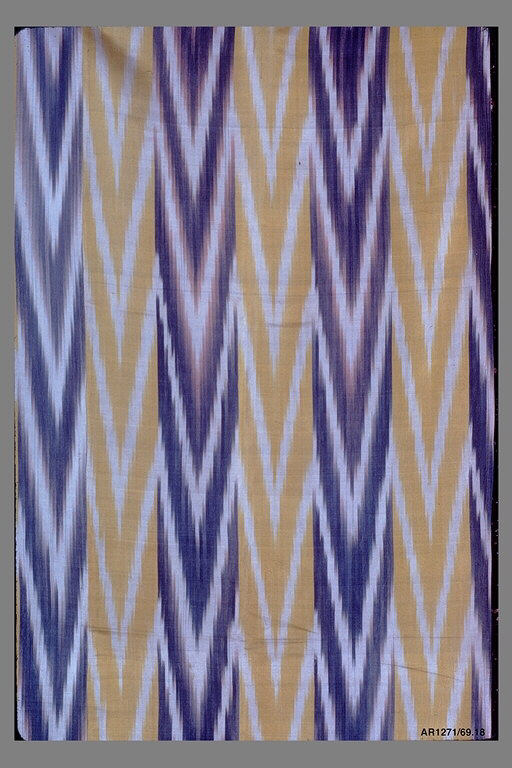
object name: length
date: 1701-1800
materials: silk